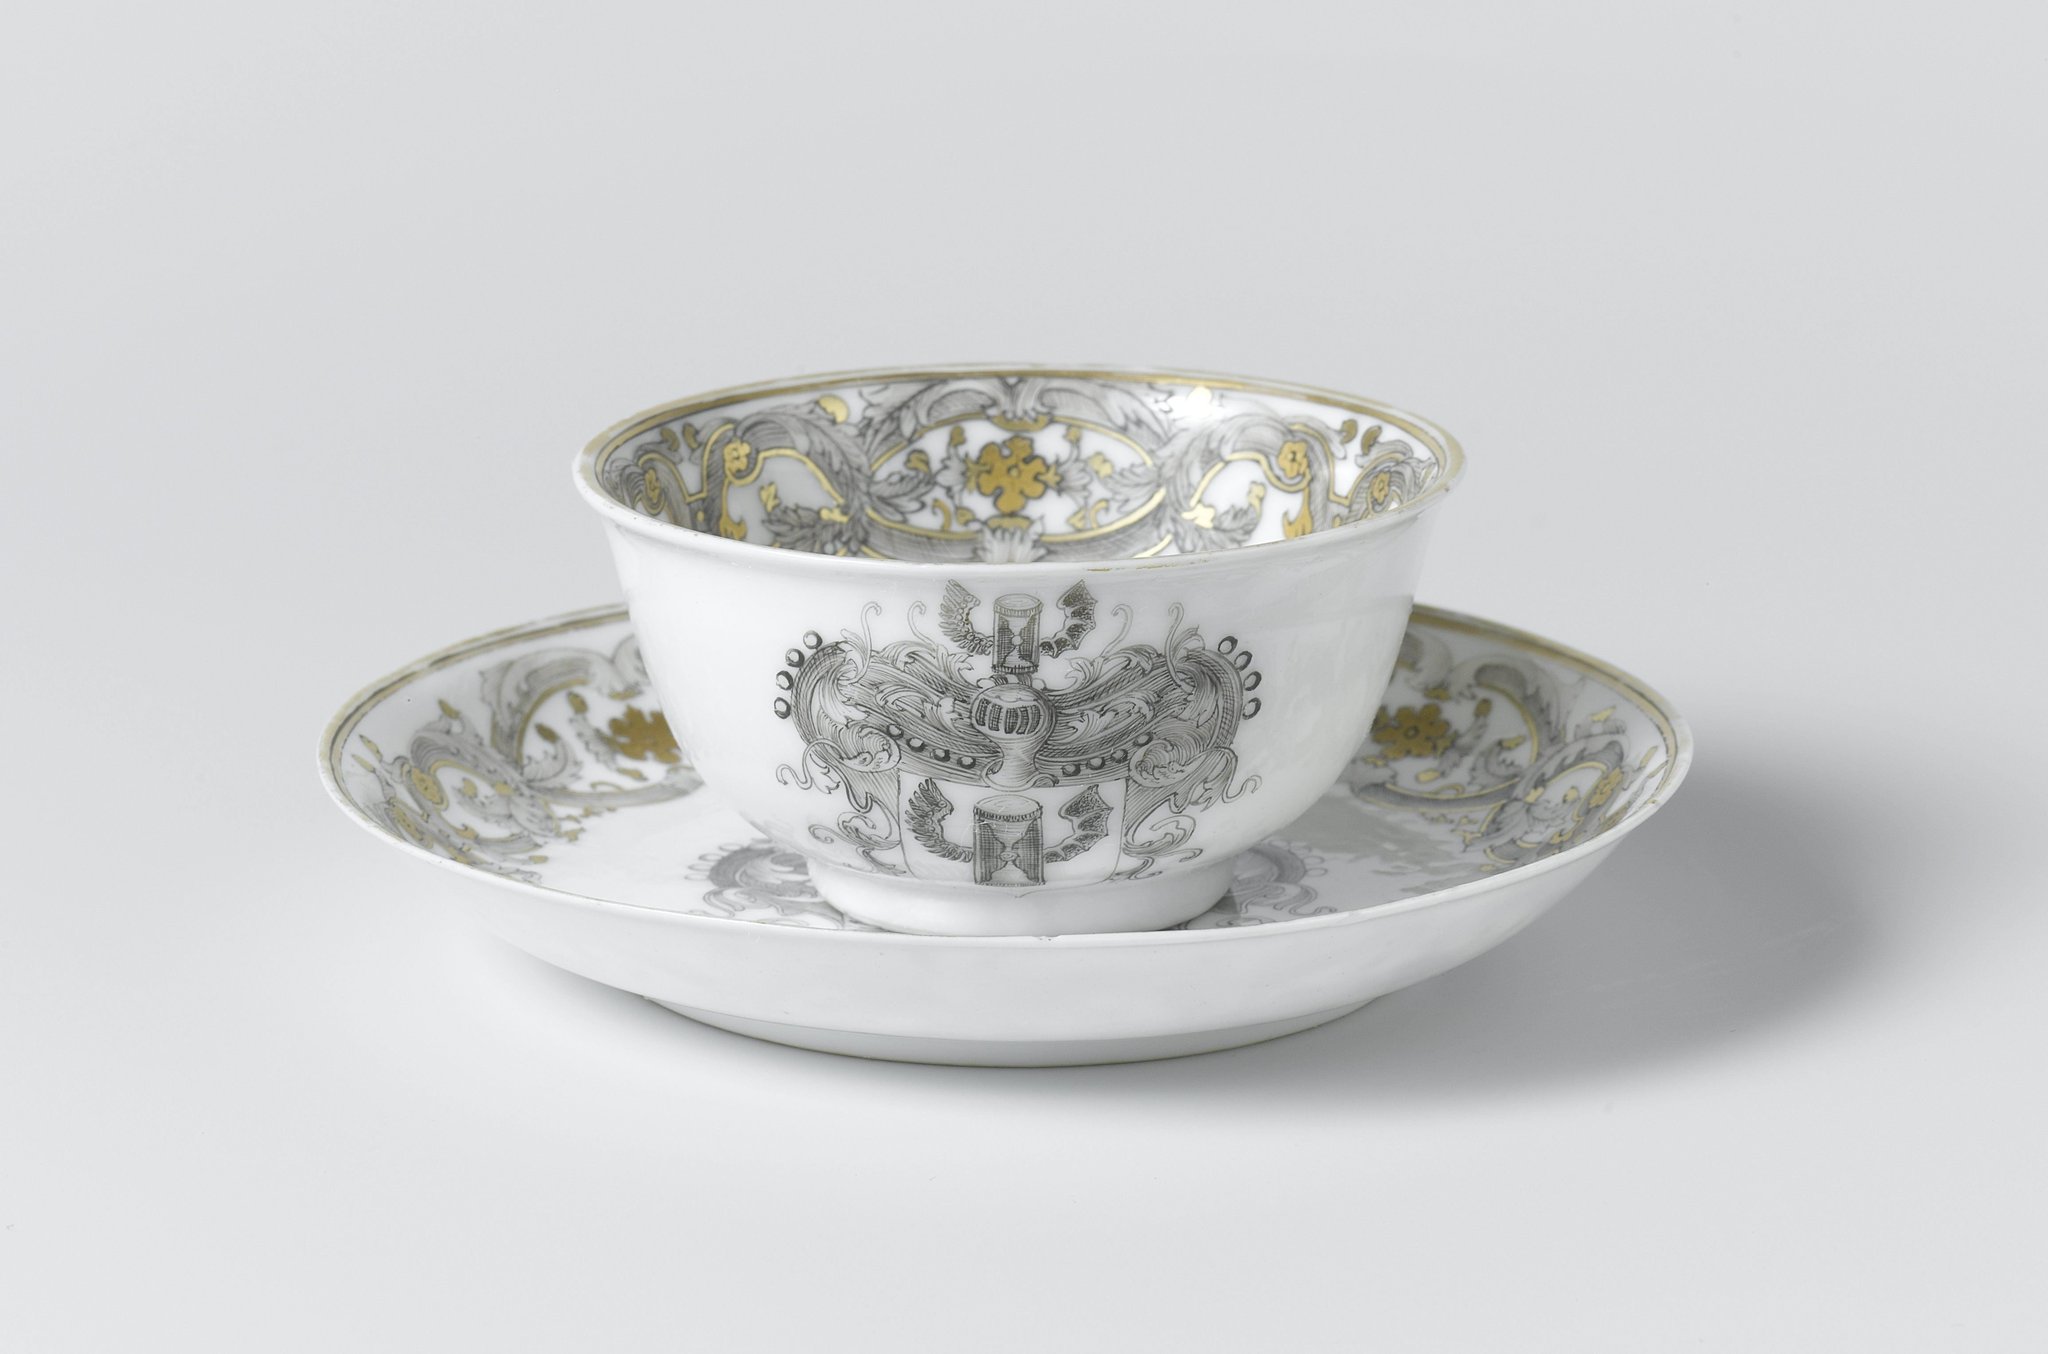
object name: kop en schotel, kop en schotel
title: Bell-shaped cup and saucer with the arms of the De Marre family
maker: Anonymous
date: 1735-1740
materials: glaze, gold, paint, porcelain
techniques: firing, gilding, turning, vitrification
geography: china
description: Deze kop en schotel zijn onderdeel van een theeservies dat waarschijnlijk is besteld door Christoffel de Marre (overleden 1745). Hij was principaal of eerste supercargo van de VOC vestiging in Kanton (1737, 1738, 1740, 1742). Zijn laatste functie was visitateur-generaal. Het theeservies kan ook mogelijk besteld zijn door Jan de Marre (1696-1763). Hij begon zijn carrière bij de VOC in 1708. In 1732 verhuisde hij naar Amsterdam waar hij boekhouder van het Amsterdamse theater werd. Hij schreef gedichten en toneelstukken over onder andere Jacoba van Beieren (1736) en over de VOC, bestaande uit zes delen genaamd ‘Batavia, begrepen in zes boeken’.